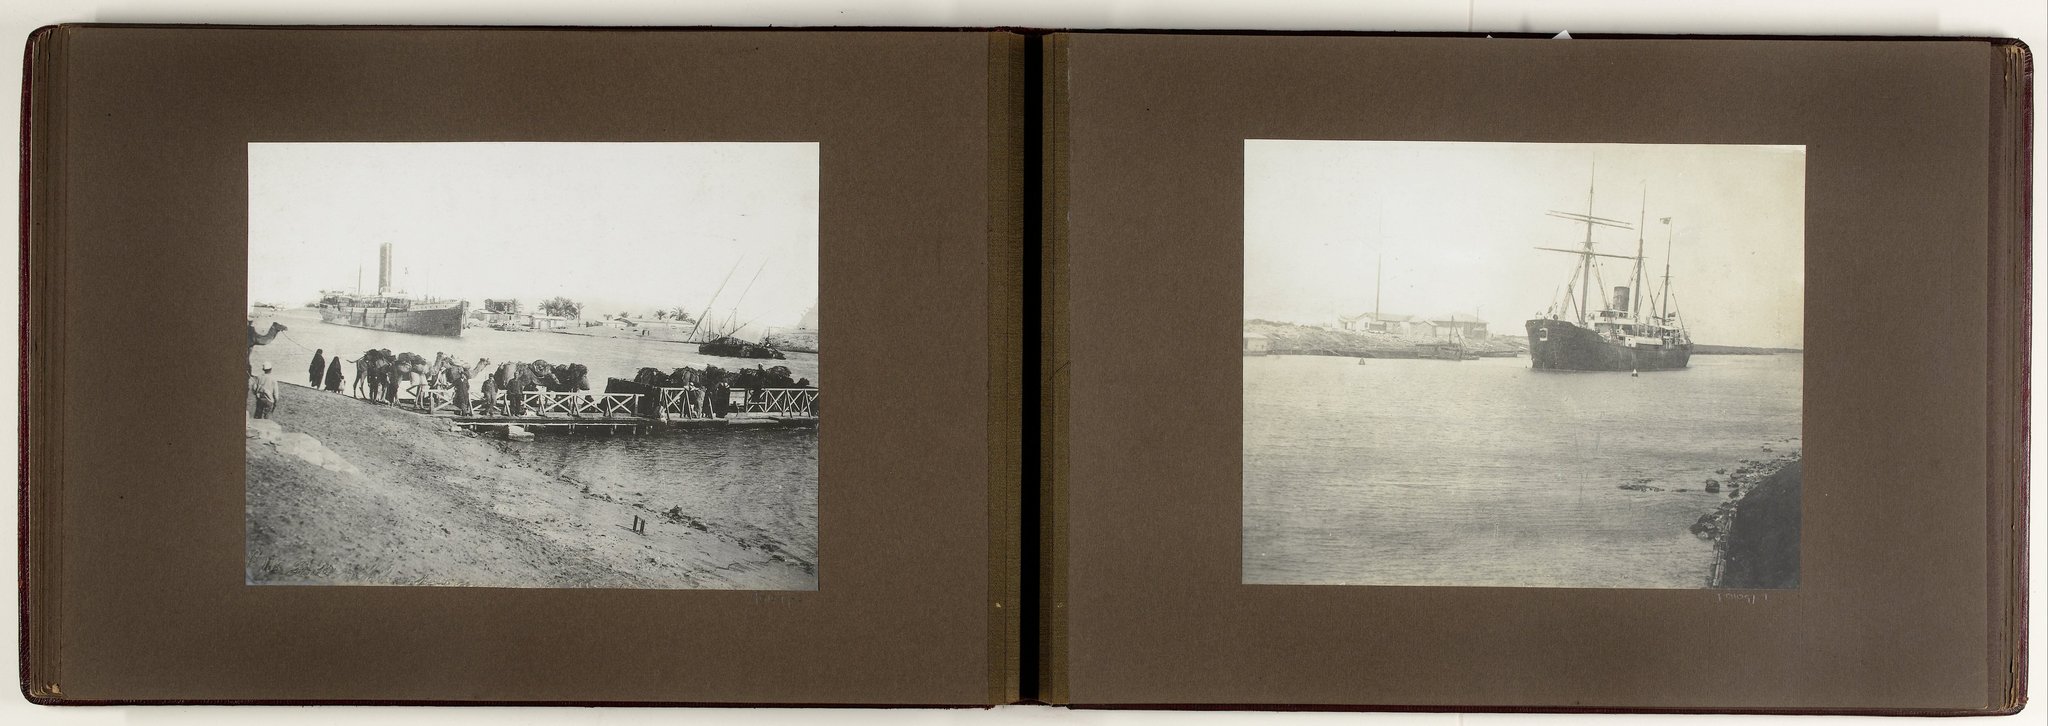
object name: photograph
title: Handelaren met lastdieren bij een haven, vermoedelijk aan het Suezkanaal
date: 1880-1900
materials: paper, photographic support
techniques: gelatin silver print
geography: suez canal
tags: harbour, hoofed animals, pier, quay, wharf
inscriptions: inscription: ‘[...]’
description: Onderdeel van Reisalbum met foto's van Duitsland, Zwitserland, het Suezkanaal en Nederlands-Indië.